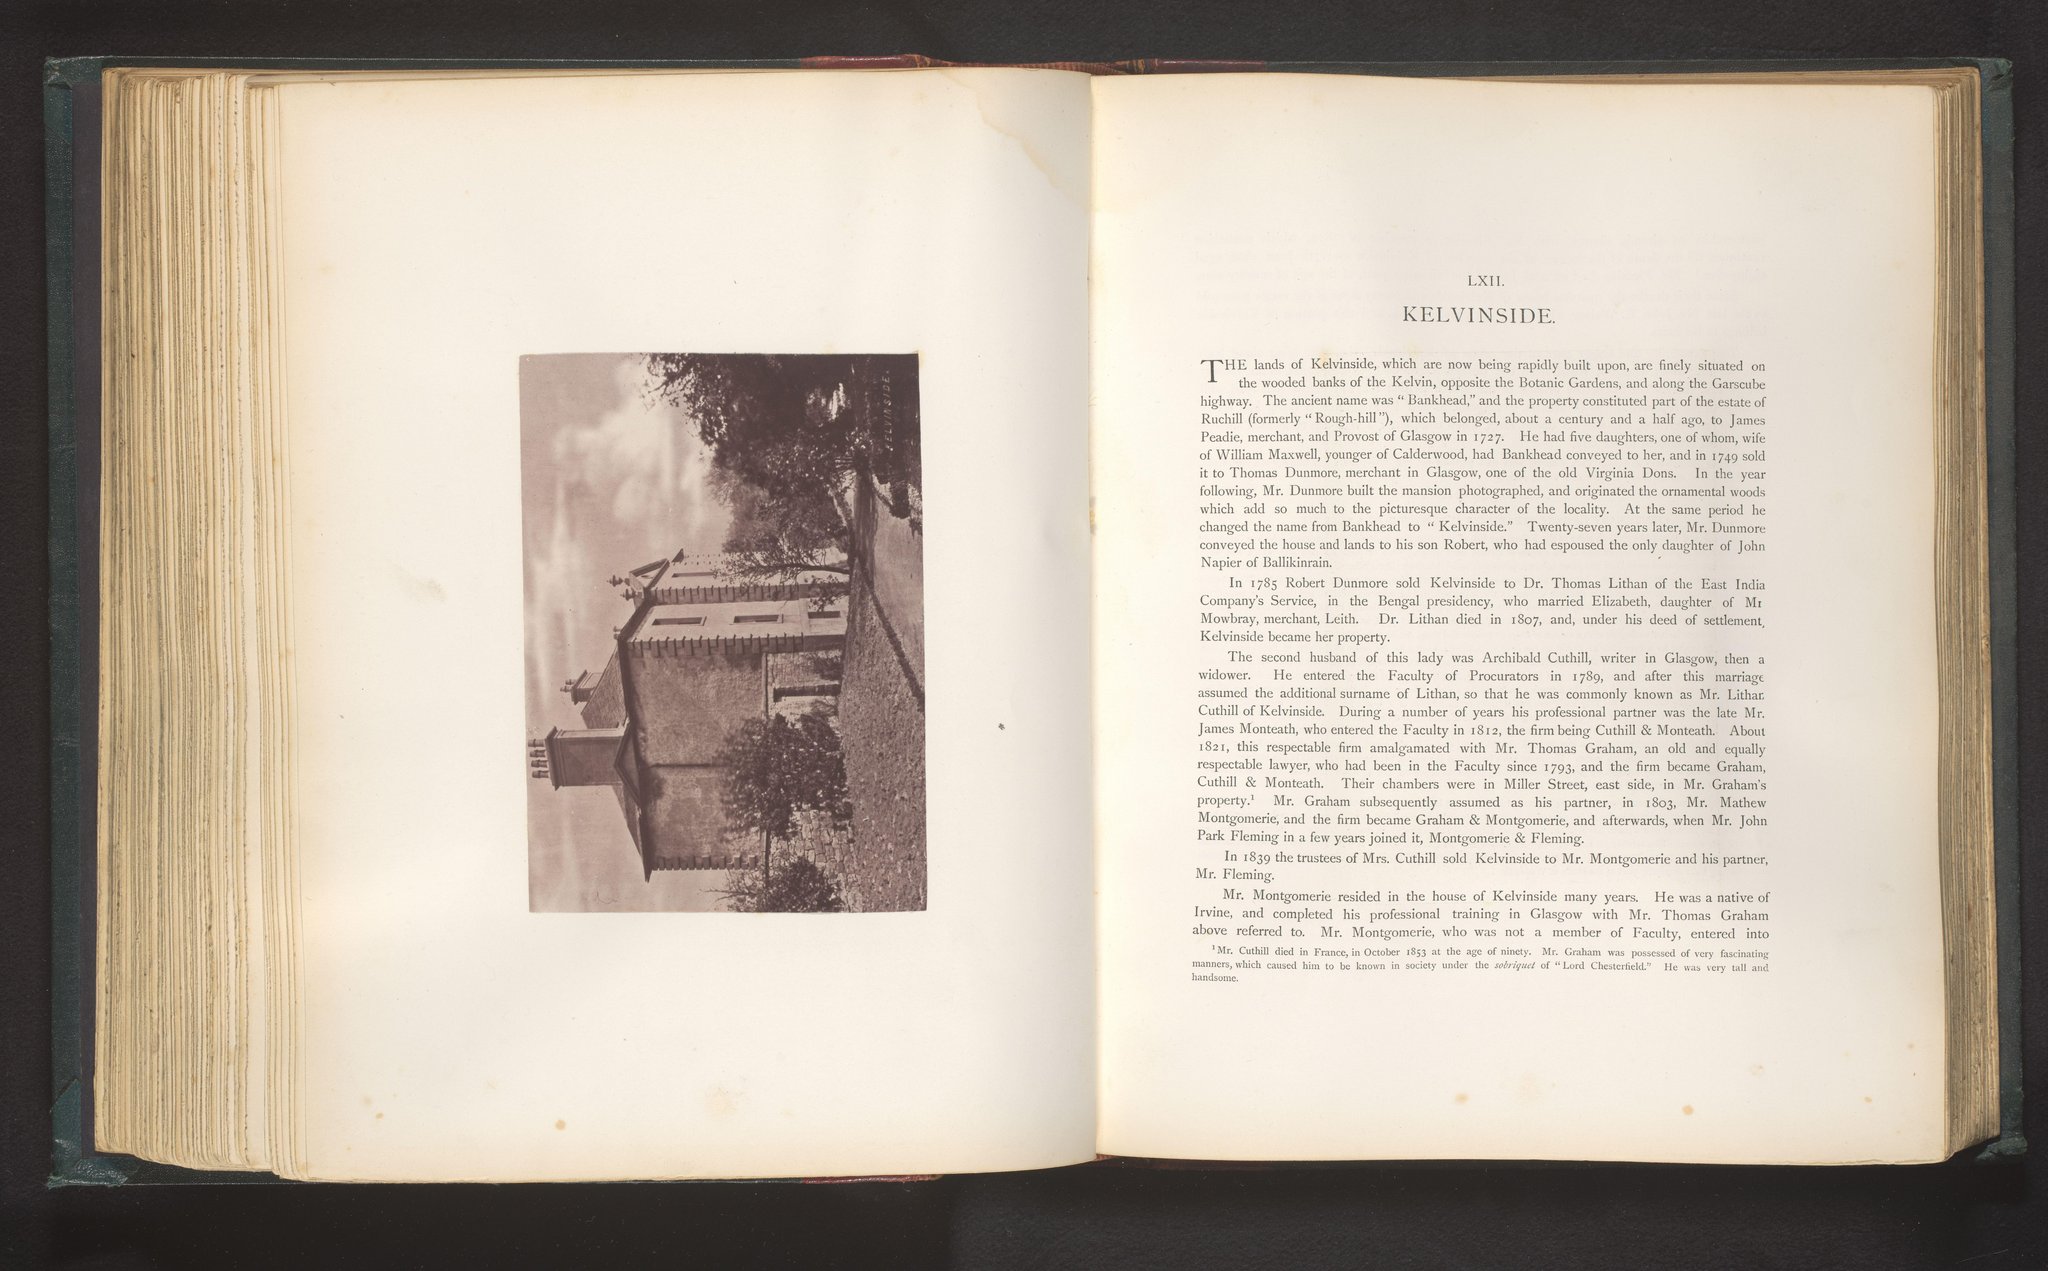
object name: photograph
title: Kelvinside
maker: thomas annan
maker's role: fotograaf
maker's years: 1829-1887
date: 1868-1878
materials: paper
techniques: carbon print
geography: glasgow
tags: rural housing, e.g. country-house, villa, cottage, façade (of house or building)